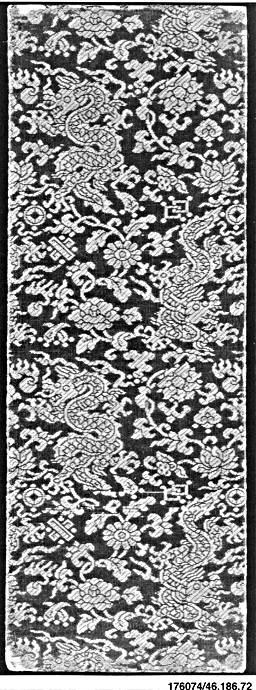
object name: sutra cover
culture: chinese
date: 1501-1600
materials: silk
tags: dragons,flowers